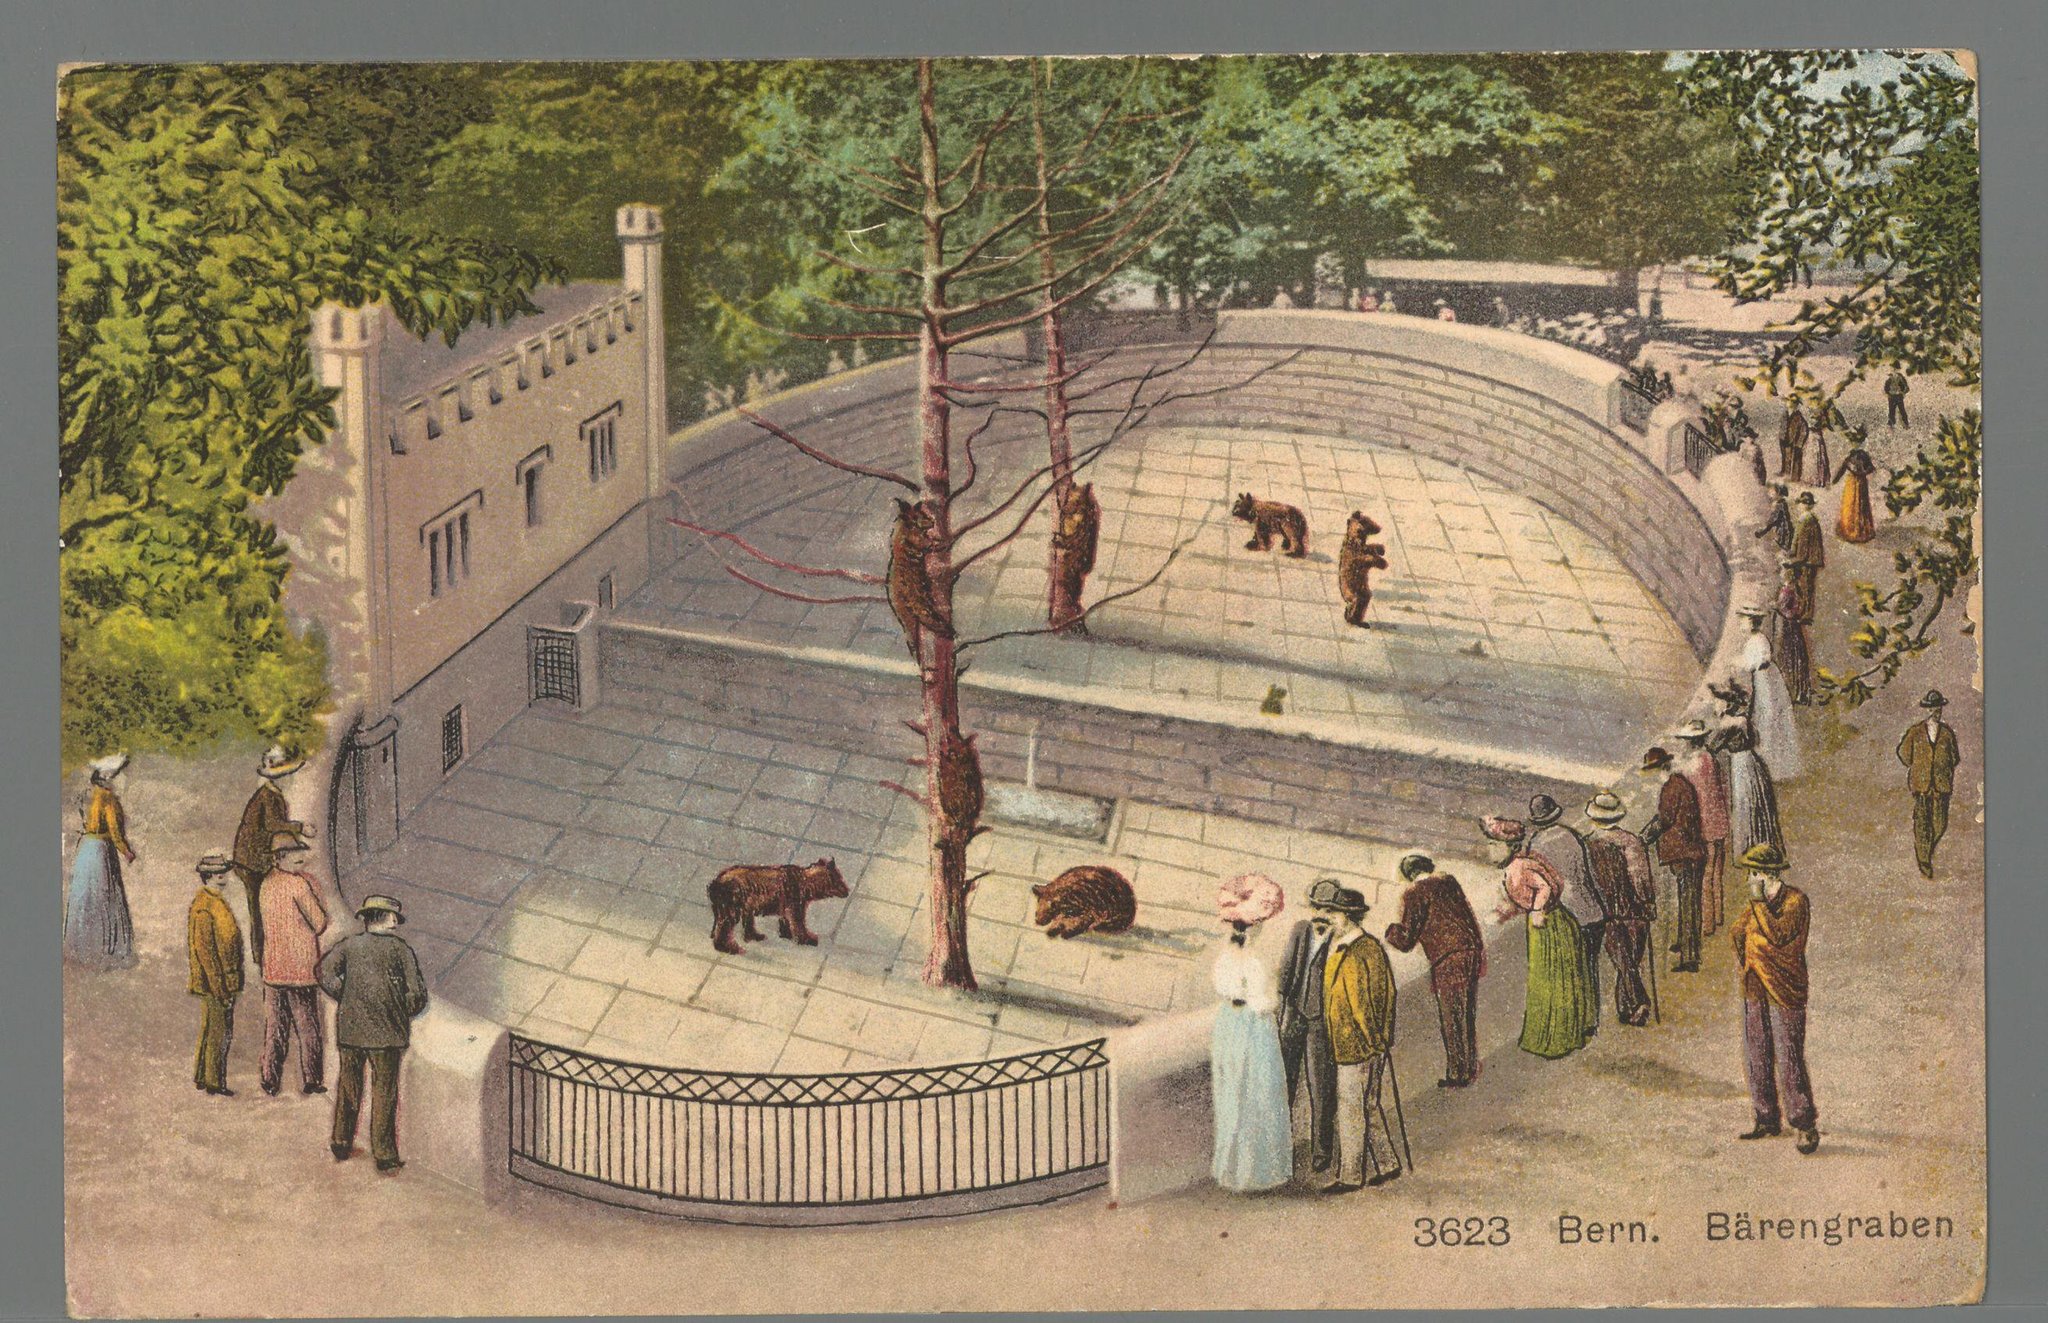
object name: print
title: Bern. Bärengraben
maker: Anonymous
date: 1905-1920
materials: cardboard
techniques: lithograph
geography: zurich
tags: public gardens, park (+ city(-scape) with figures, staffage), bear-pit, beasts of prey, predatory animals: bear